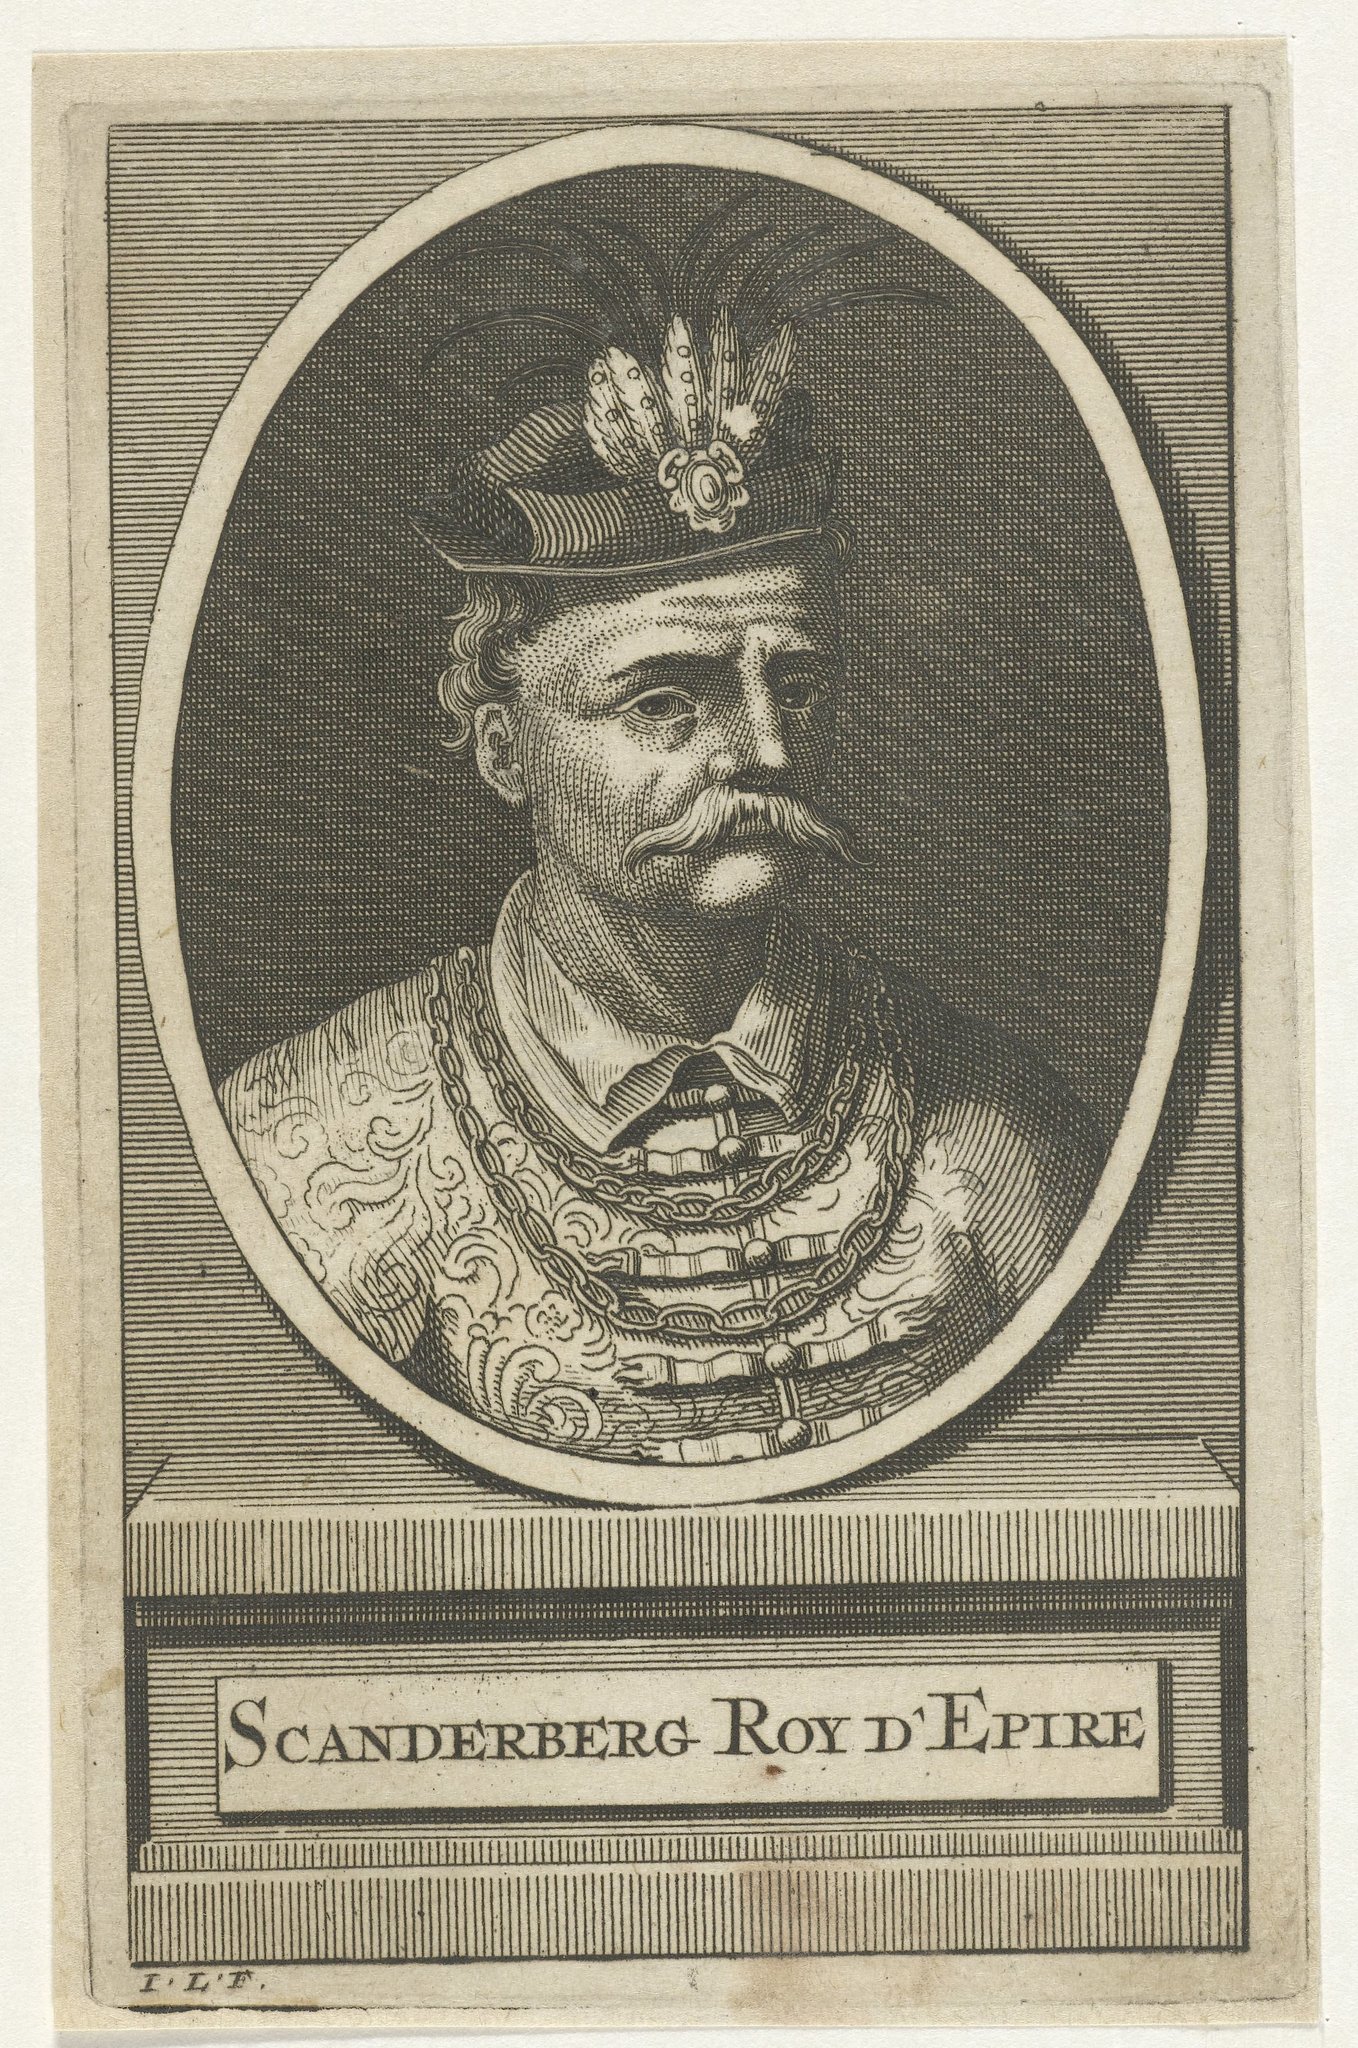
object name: print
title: Portret van Georg Skanderberg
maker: jan lamsvelt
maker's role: print maker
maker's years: 1674-1743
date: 1684-1743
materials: paper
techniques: engraving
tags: krujë, lezha, generaal, skanderbeg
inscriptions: collector's mark: Lugt 2228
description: Portretbuste in ovaal naar rechts van de Albanese vorst Georg Skanderberg, met gevederd hoofddeksel en gehuld in een harnas. Onder het ovaal staan op een sokkel de naam en titel van de geportretteerde vermeld.